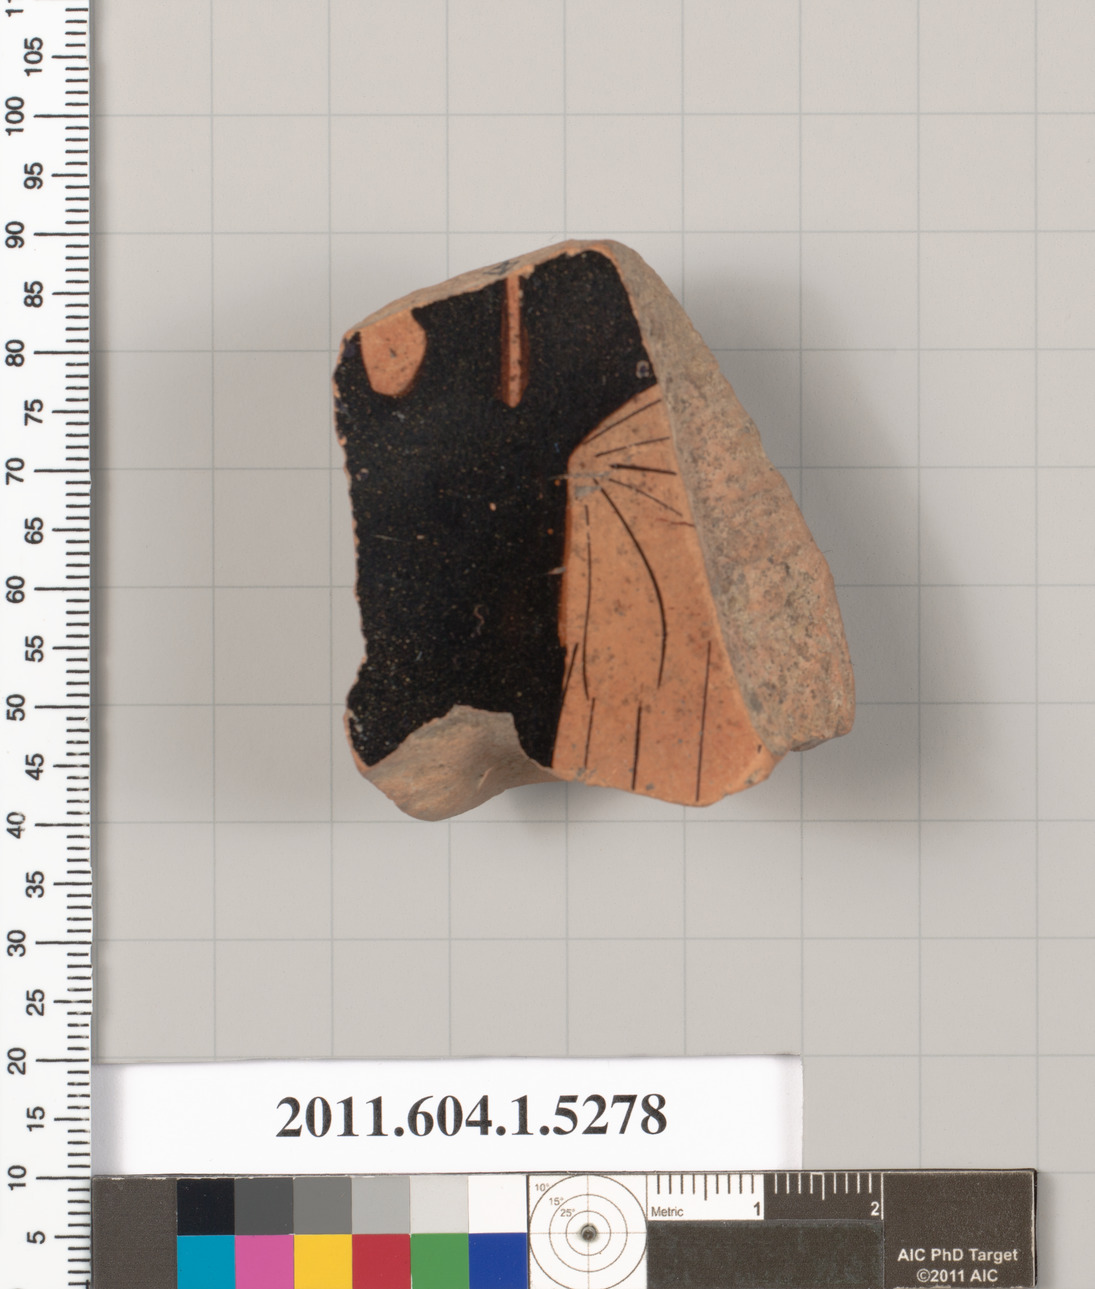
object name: kylix fragment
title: Terracotta fragment of a kylix (drinking cup)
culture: greek, attic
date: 475-451 BCE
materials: terracotta